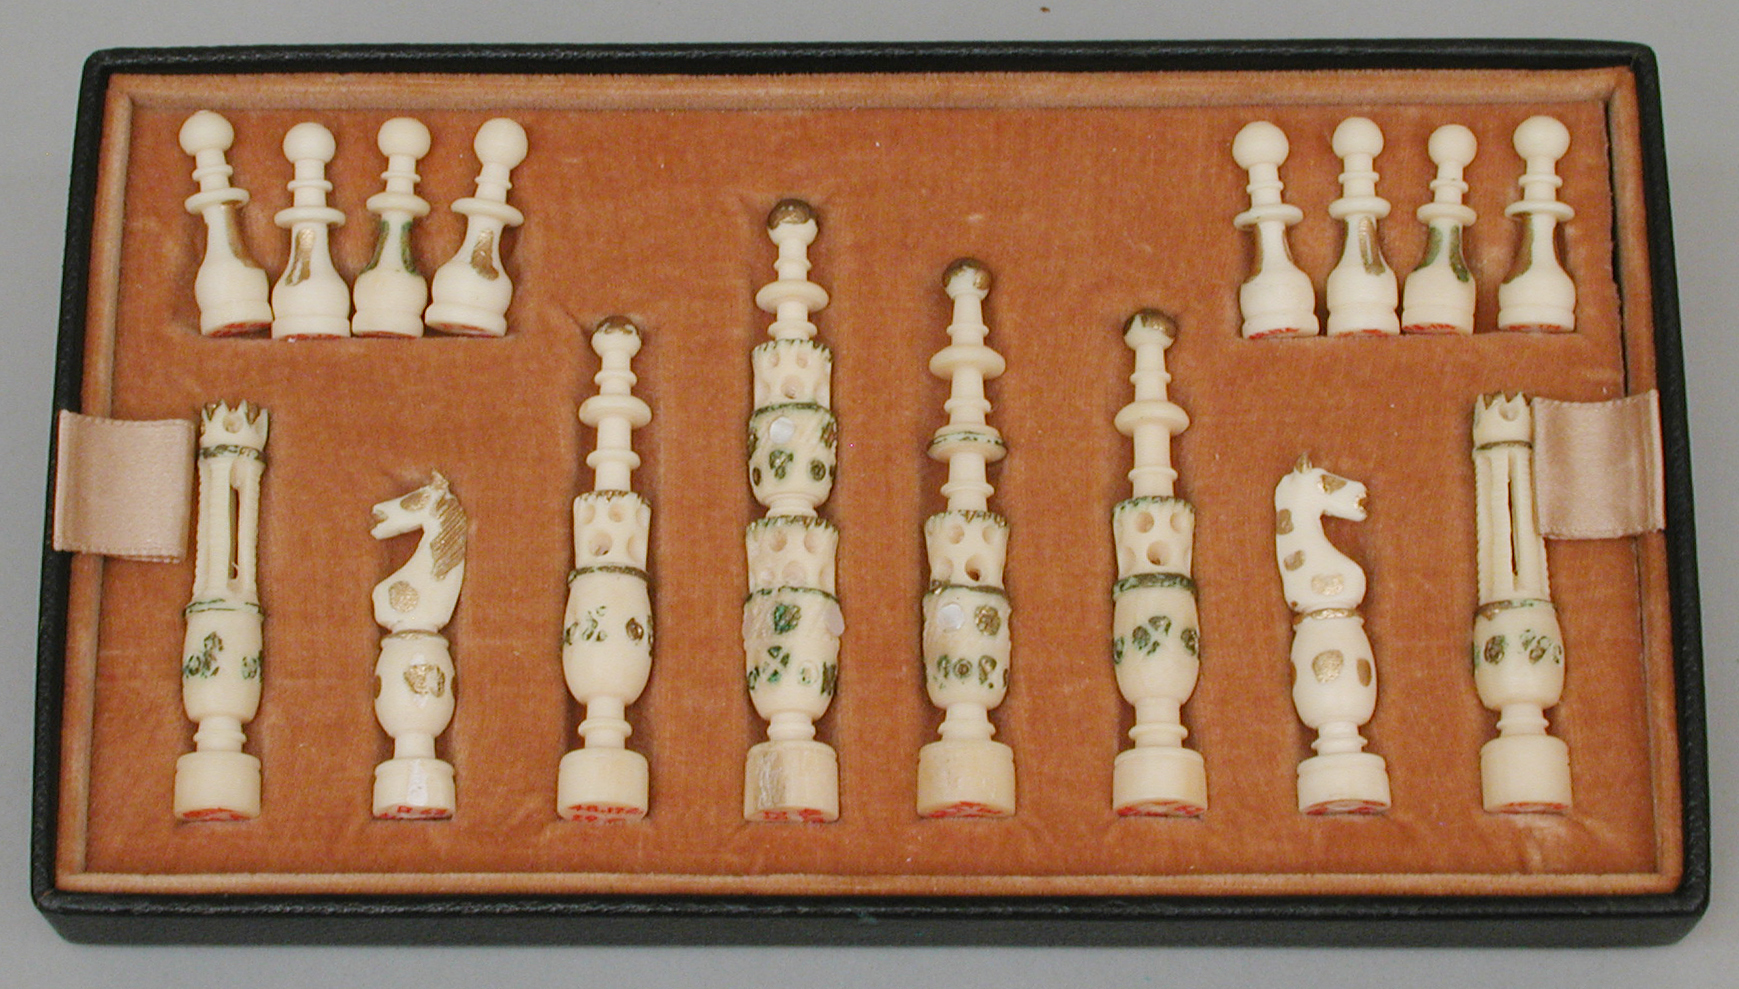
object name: chessman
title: Chessmen (32) and box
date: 1801-1900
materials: bone, wood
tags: chess